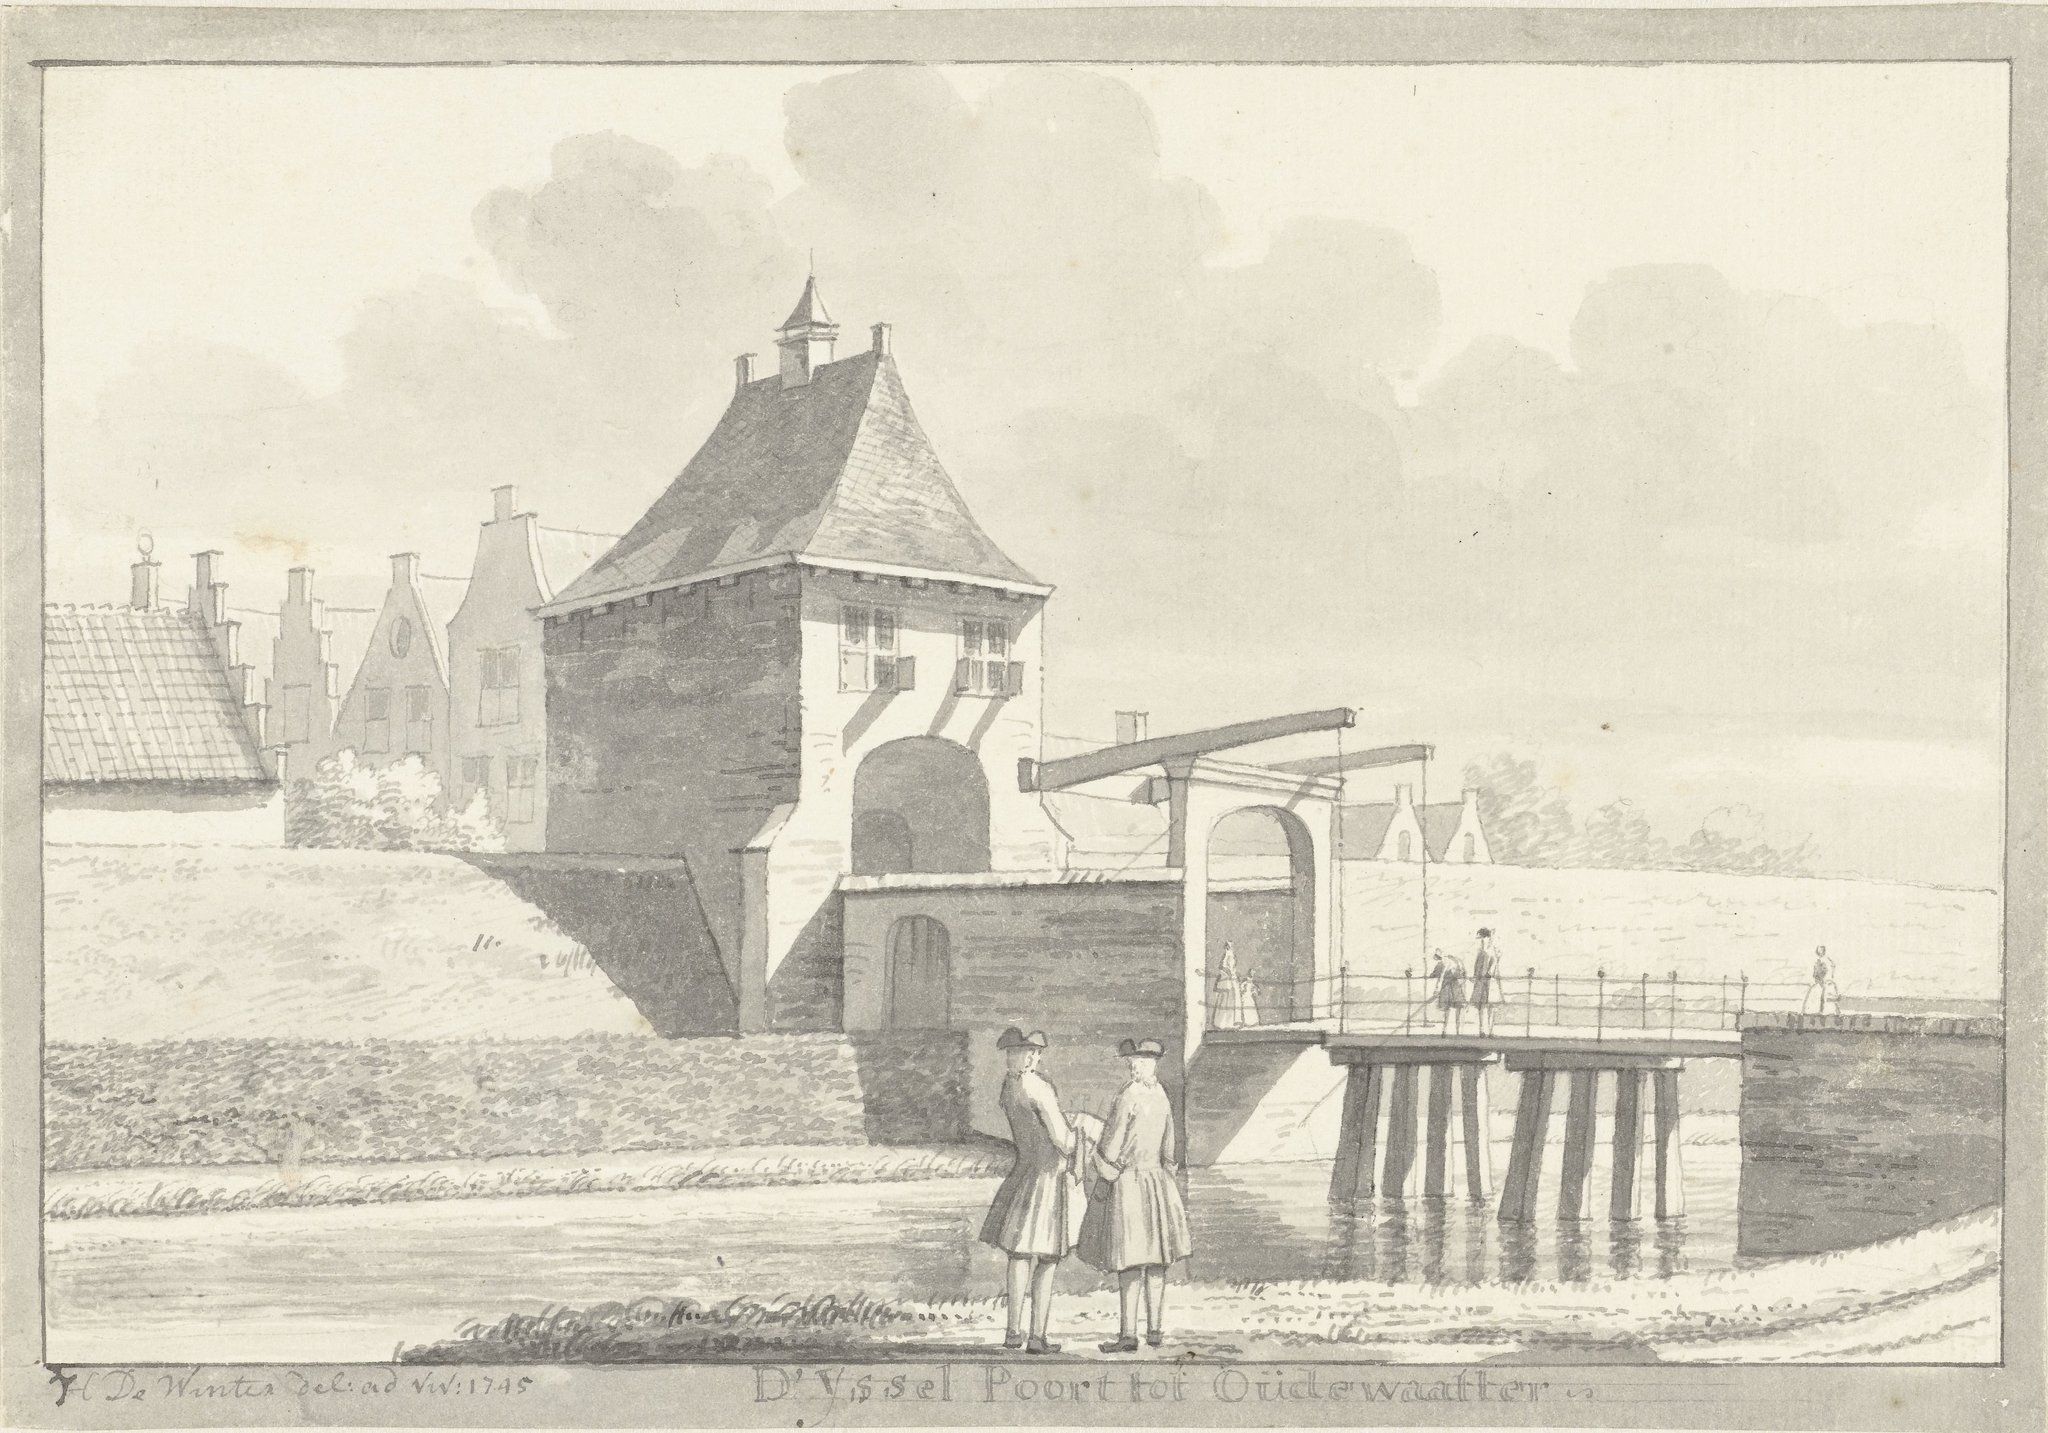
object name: drawing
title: De IJsselpoort in Oudewater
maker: hendrik de winter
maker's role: draughtsman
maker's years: 1717-1790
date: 1745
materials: ink, paper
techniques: brush, pen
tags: city-walls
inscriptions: inscription: ‘H de Winter Del: ad viv: 1745 D'Yssel Poort tot Oudewaatter’